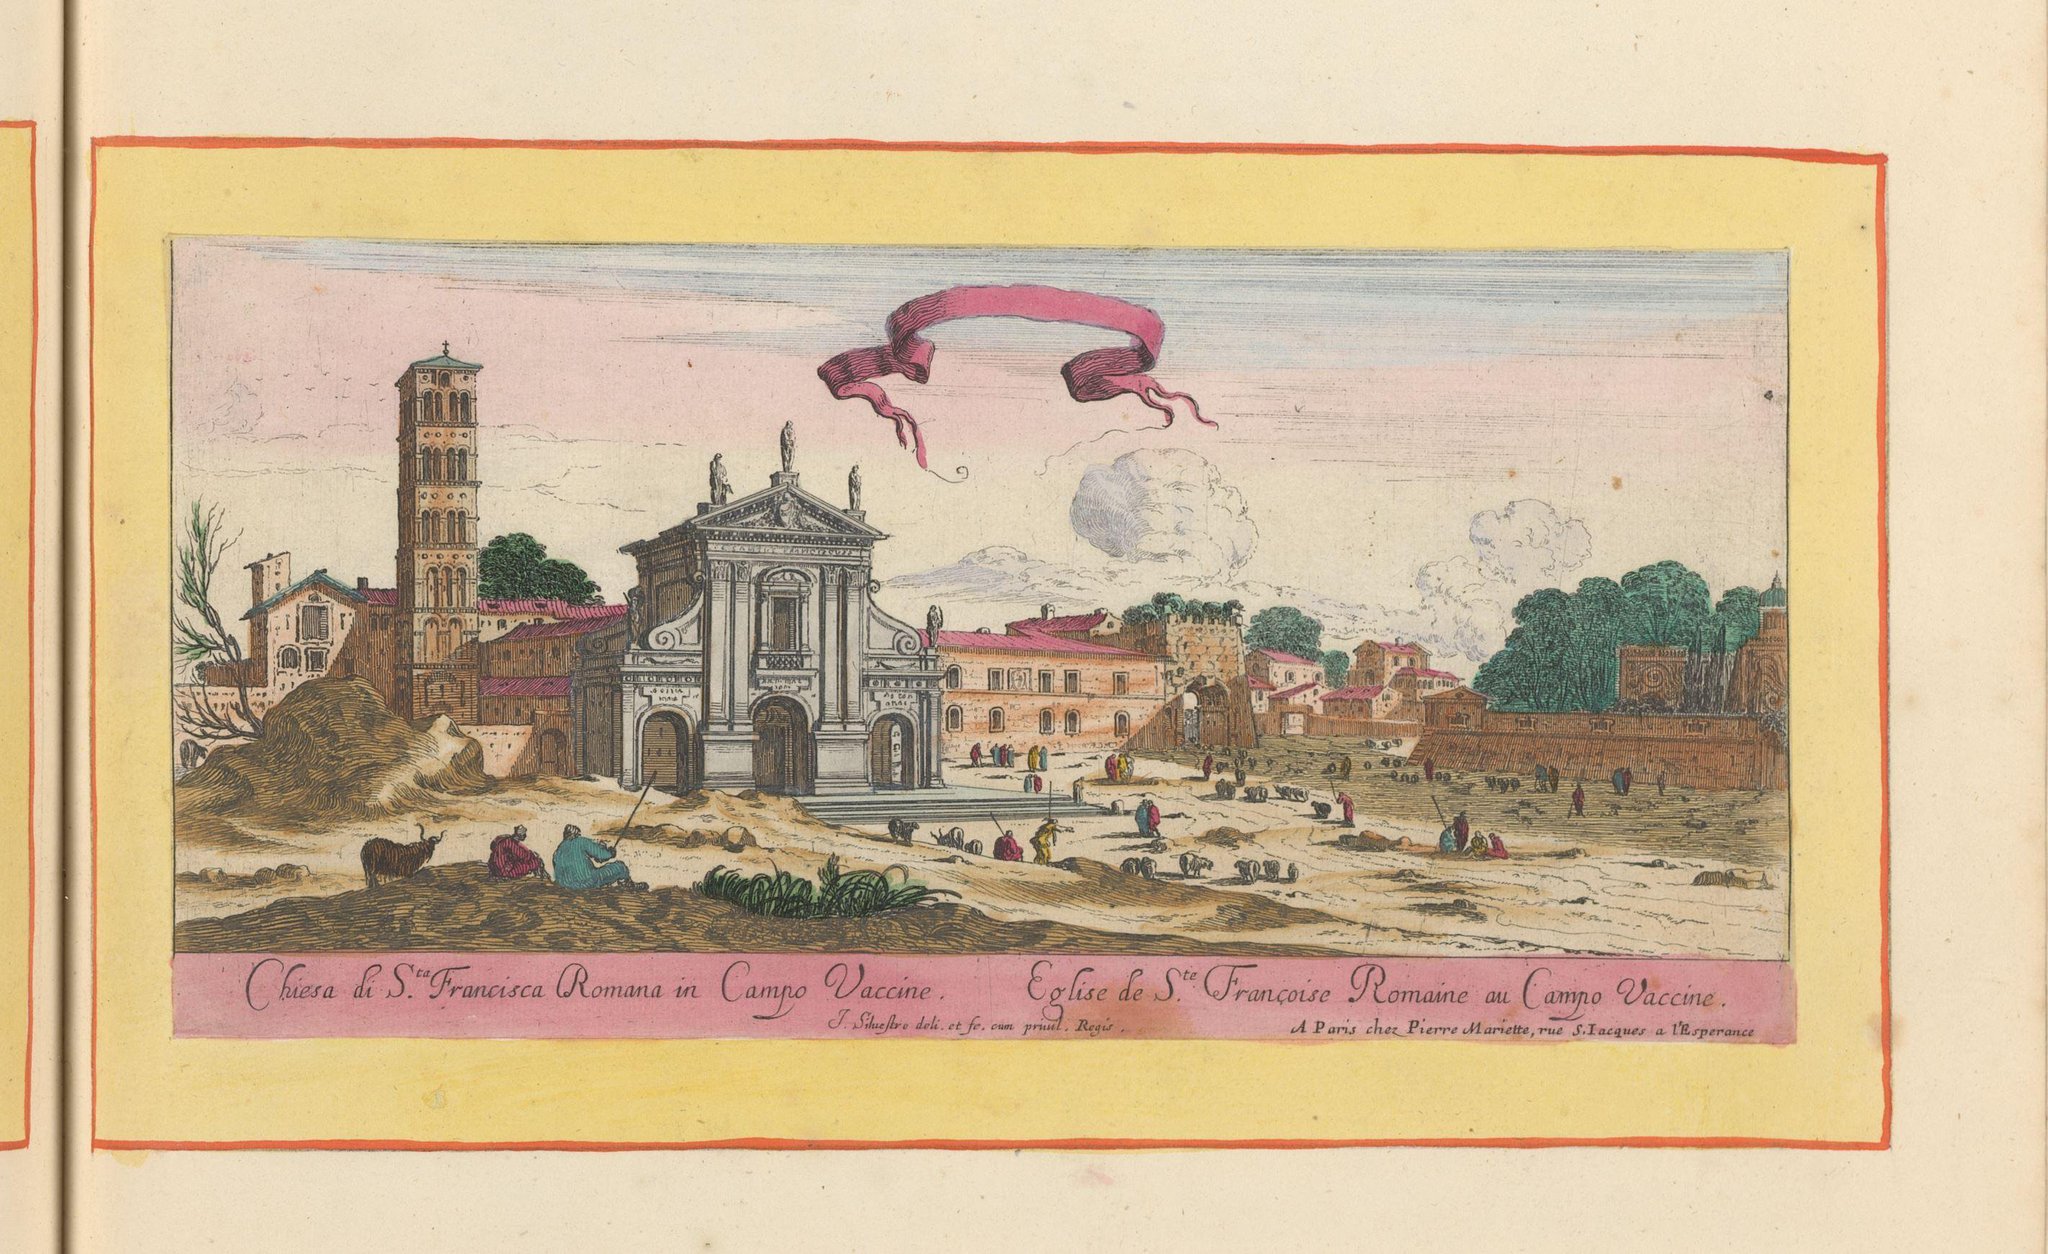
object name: album leaf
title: Santa Francesca Romana te Rome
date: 1631-1691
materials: paper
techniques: colour, etching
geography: paris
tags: city-view, and landscape with man-made constructions, church (exterior), landscape with ruins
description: Gezicht op de kerk de Santa Francesca Romana op het Forum Romanum te Rome. Midden boven een lege banderol. Titel in het Italiaans en Frans in de ondermarge. Prent maakt deel uit van een album.